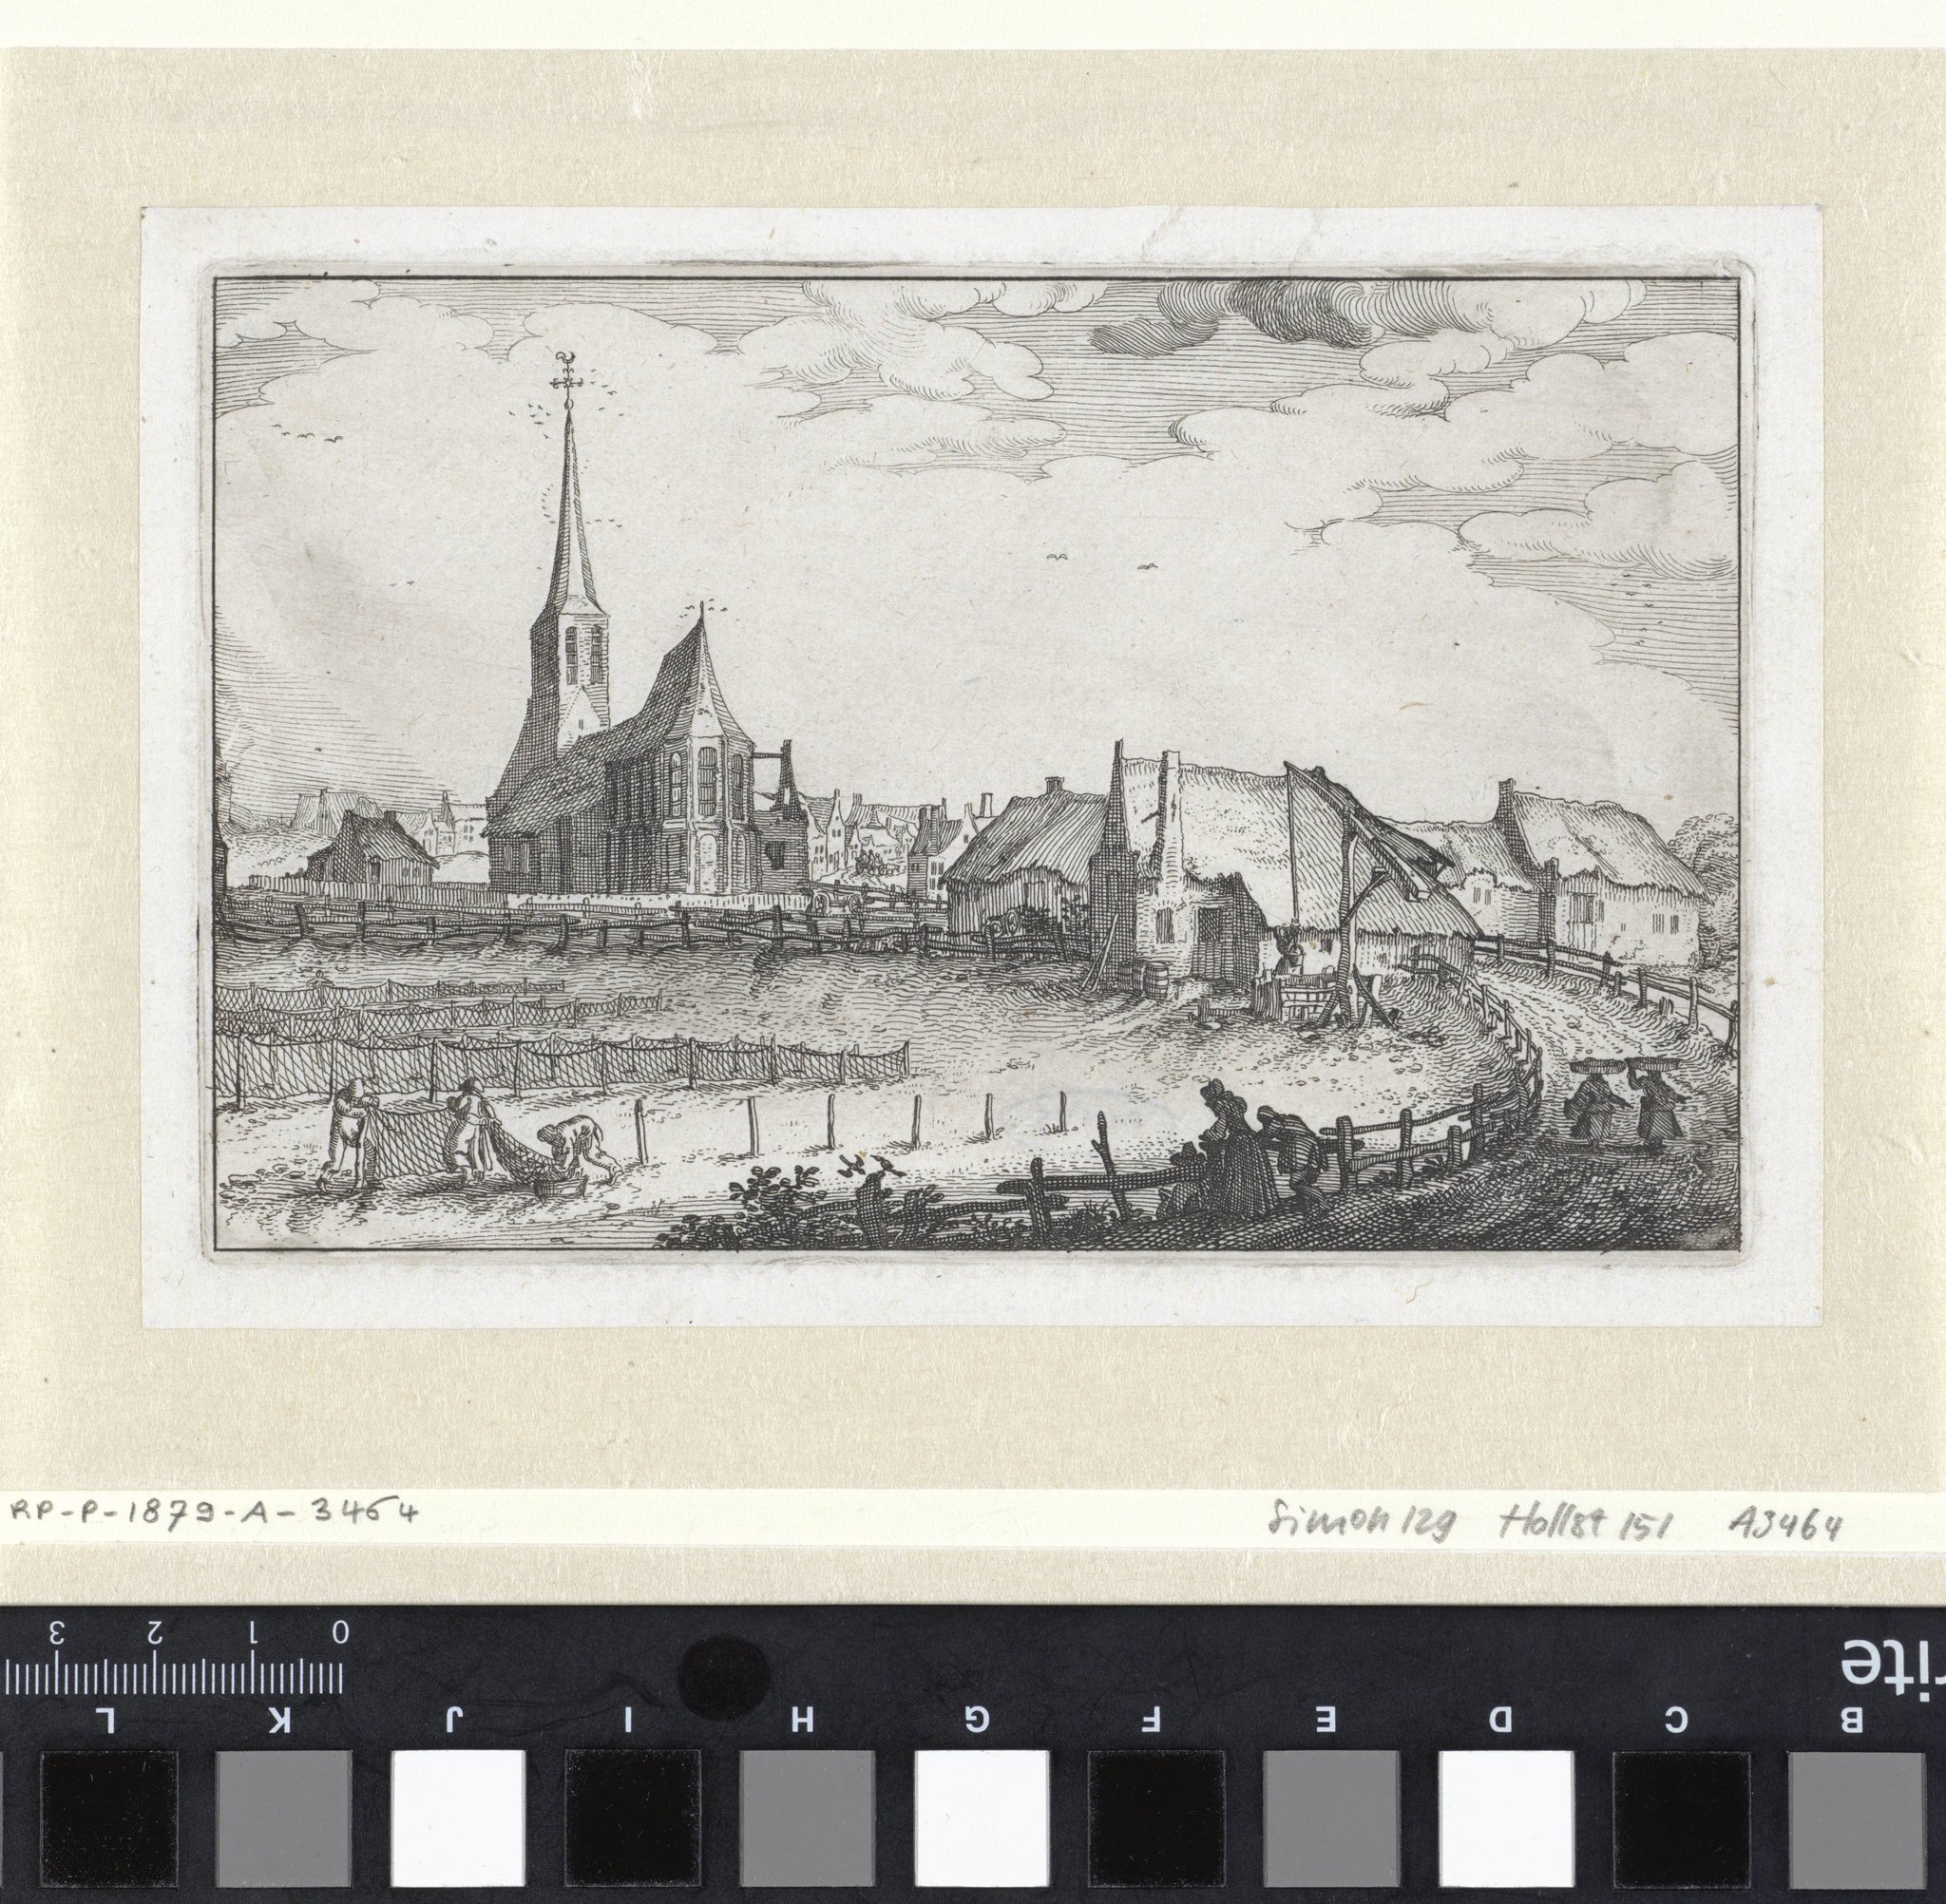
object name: print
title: Zandvoort aan Zee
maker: claes jansz. visscher (ii)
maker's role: draughtsman, print maker, publisher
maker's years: 1586-1652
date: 1612-1652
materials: paper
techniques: etching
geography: amsterdam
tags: well, church (exterior), carrying something on the head or on the shoulders, mending of fishing nets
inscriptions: collector's mark: Lugt 2228, number: ‘3’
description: Gezicht op het dorp Zandvoort aan Zee:kerk en enkele lage huisjes.Op de voorgrond worden visnetten uitgezet. Serie van twaalf genommerde prenten. Op den titel rechts de tijd, links de ijver. In het midden het Haarlemsche wapen rustende op een voetstuk met verschillende opschriften. Van onderen Plaisanten Plaetsen hier, enz